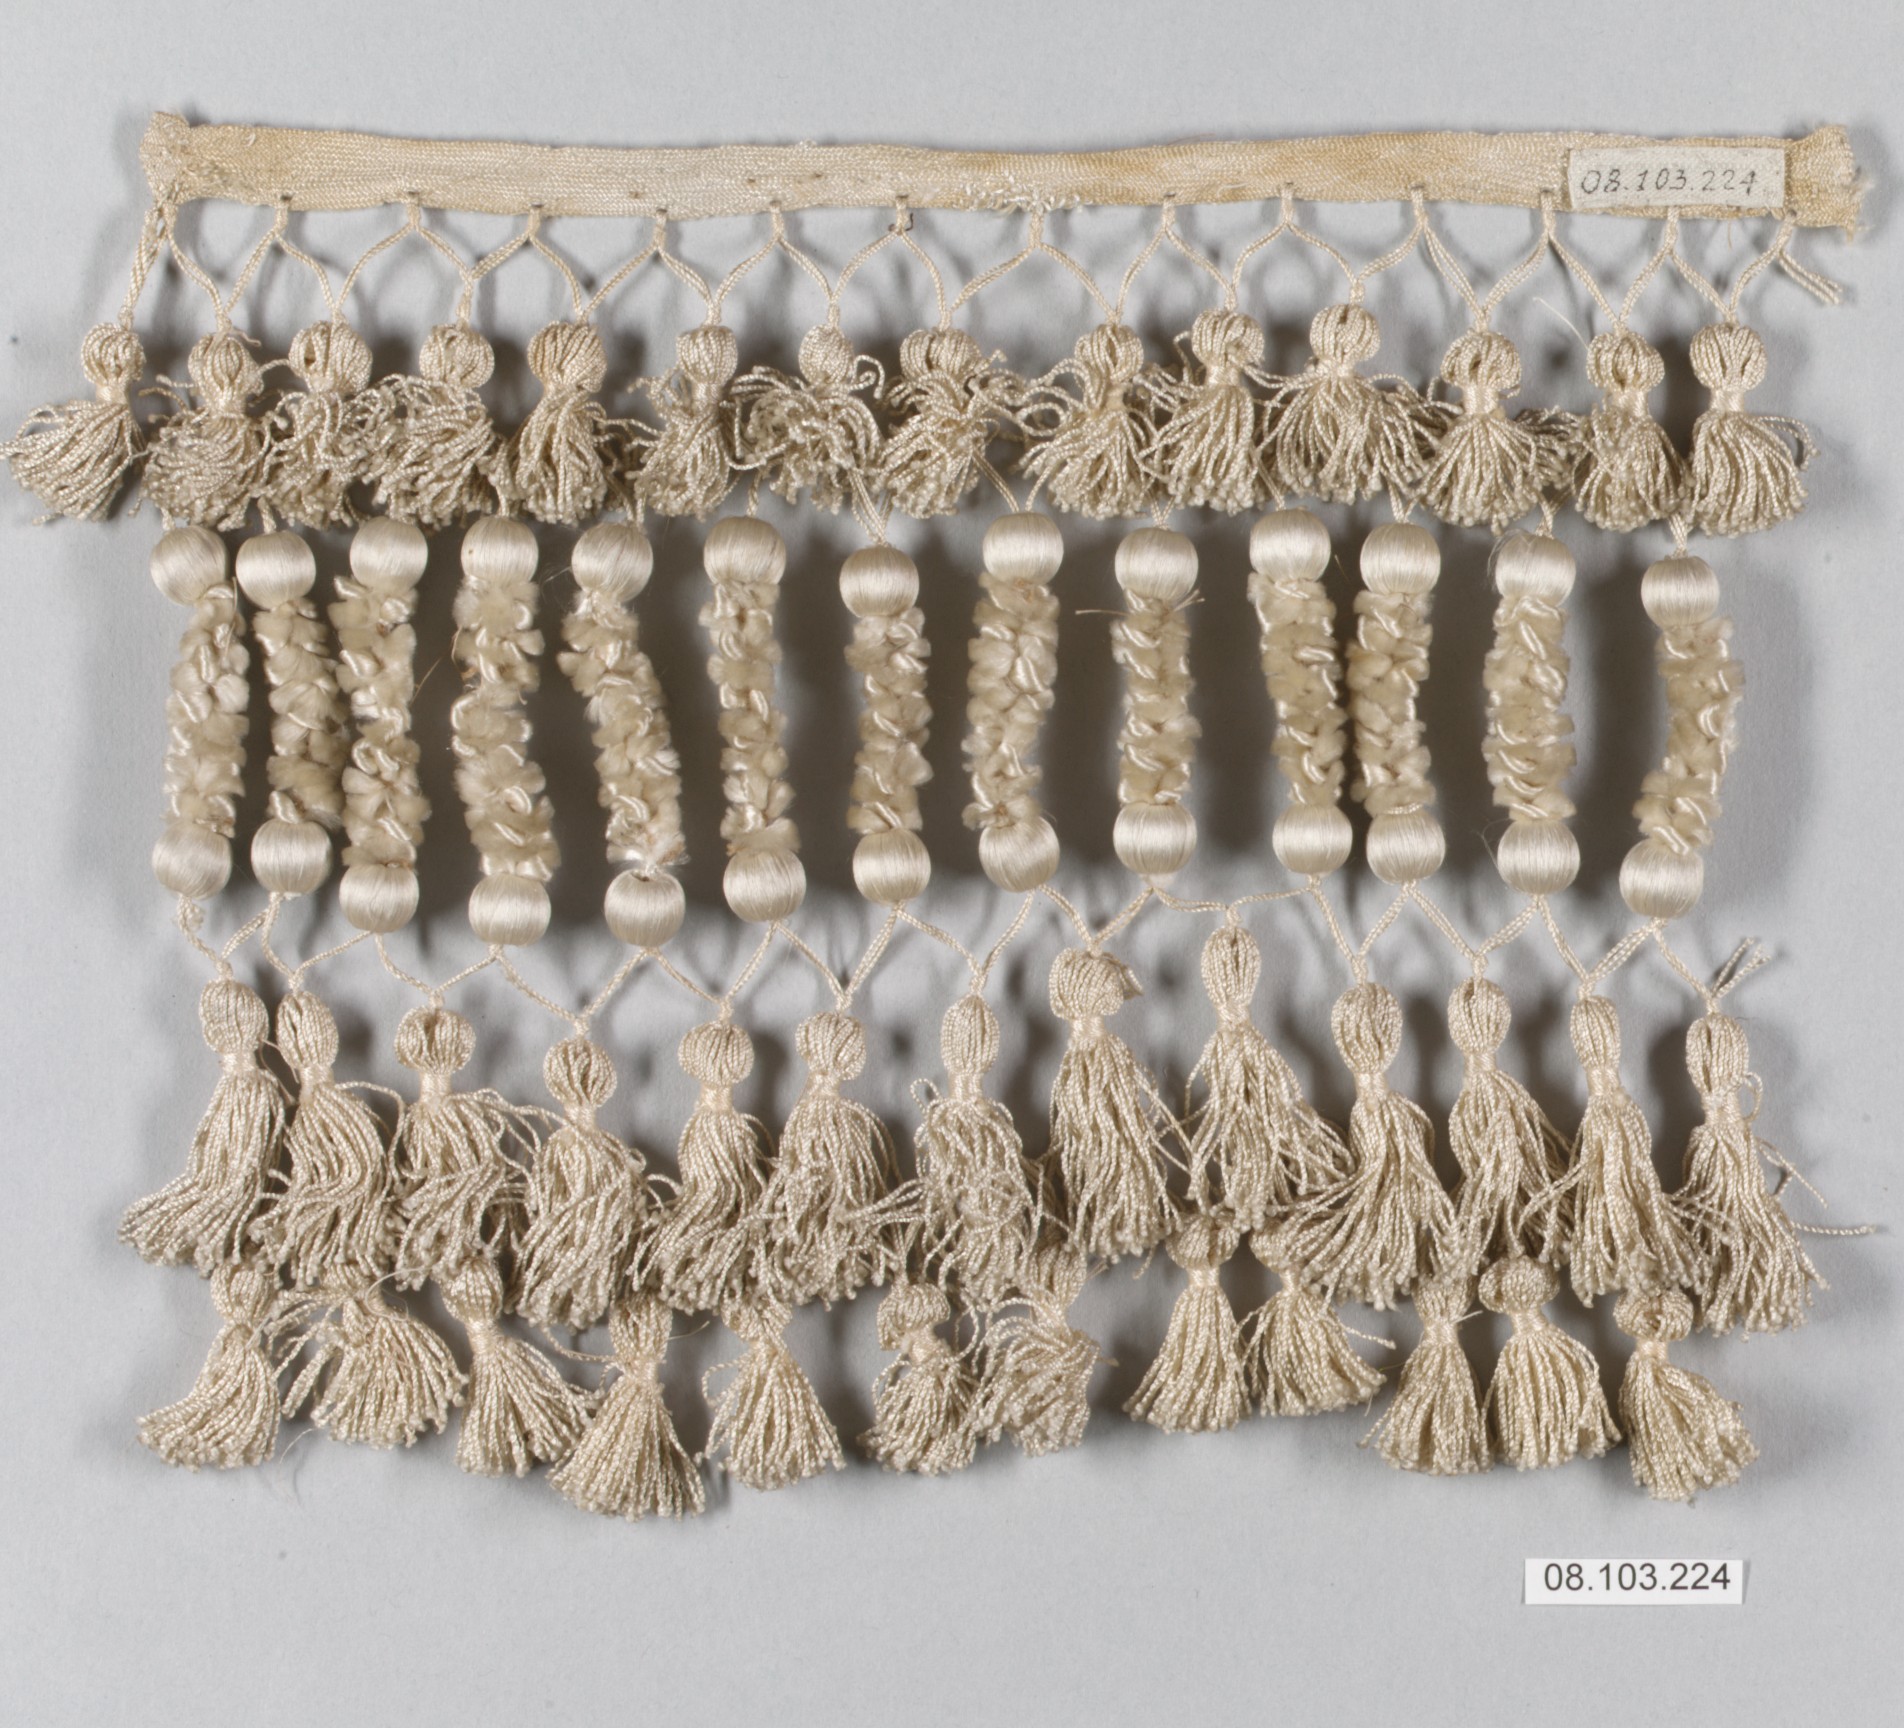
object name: fringe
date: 1801-1900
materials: silk